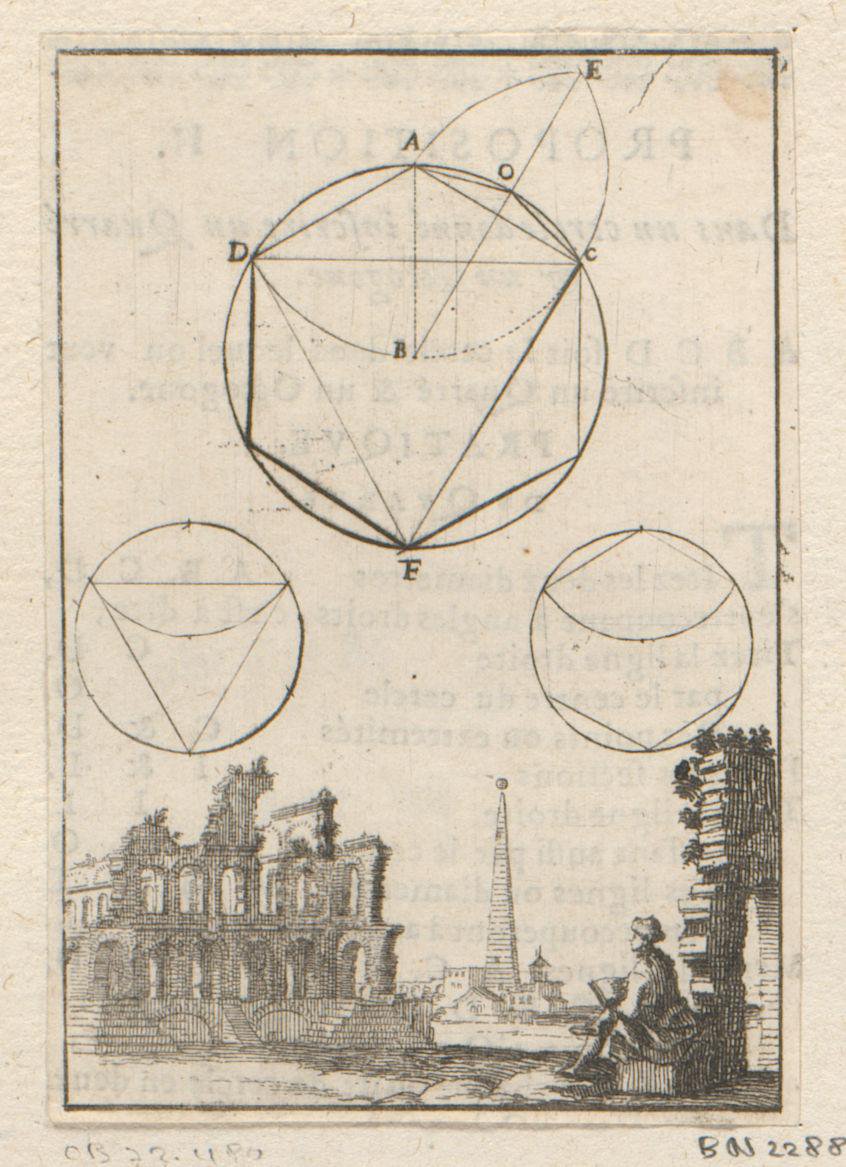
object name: print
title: Driehoek in een cirkel met onderaan een man met boek bij ruïnes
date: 1669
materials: paper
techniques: etching, letterpress printing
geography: paris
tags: triangle (~ planimetry, geometry), circle (~ planimetry, geometry)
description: Prent uit: Pratique de la géometrie, sur le papier et sur le terrain. Avec un nouvel ordre et une méthode particulière. Parijs: Thomas Jolly, 1669.